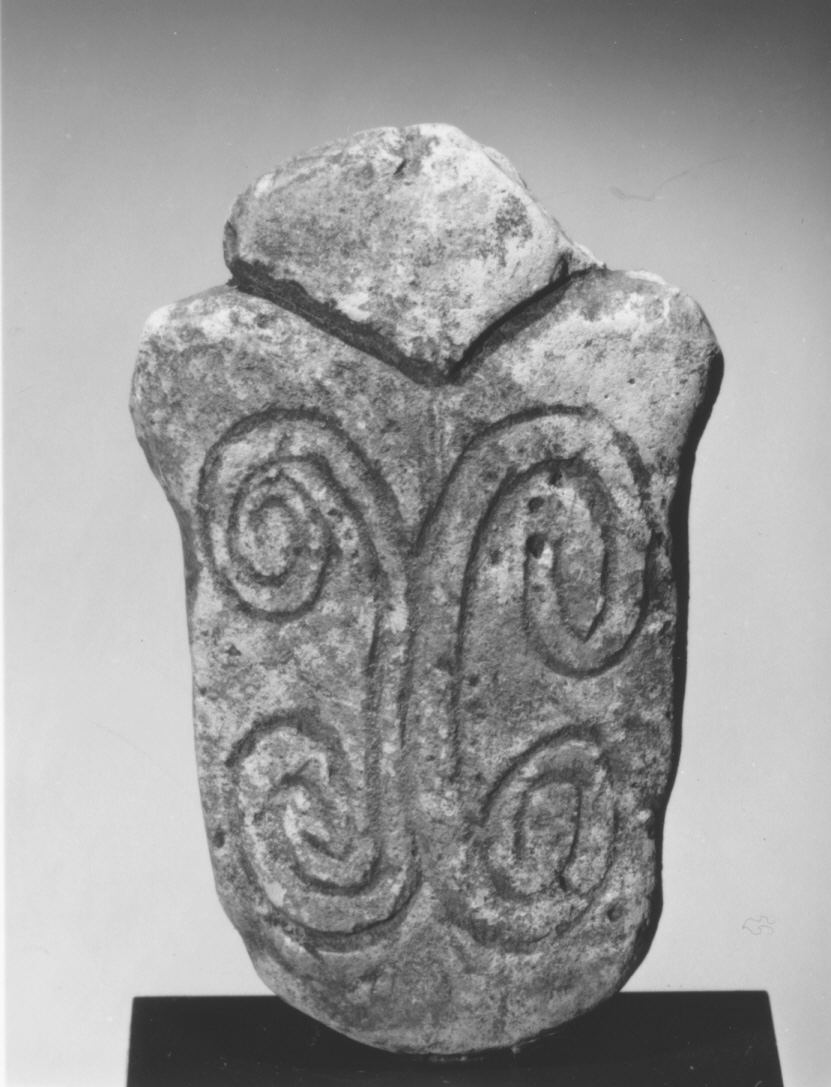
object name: plaque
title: Plaque of a Human Figure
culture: japanese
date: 1000-250 BCE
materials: stone